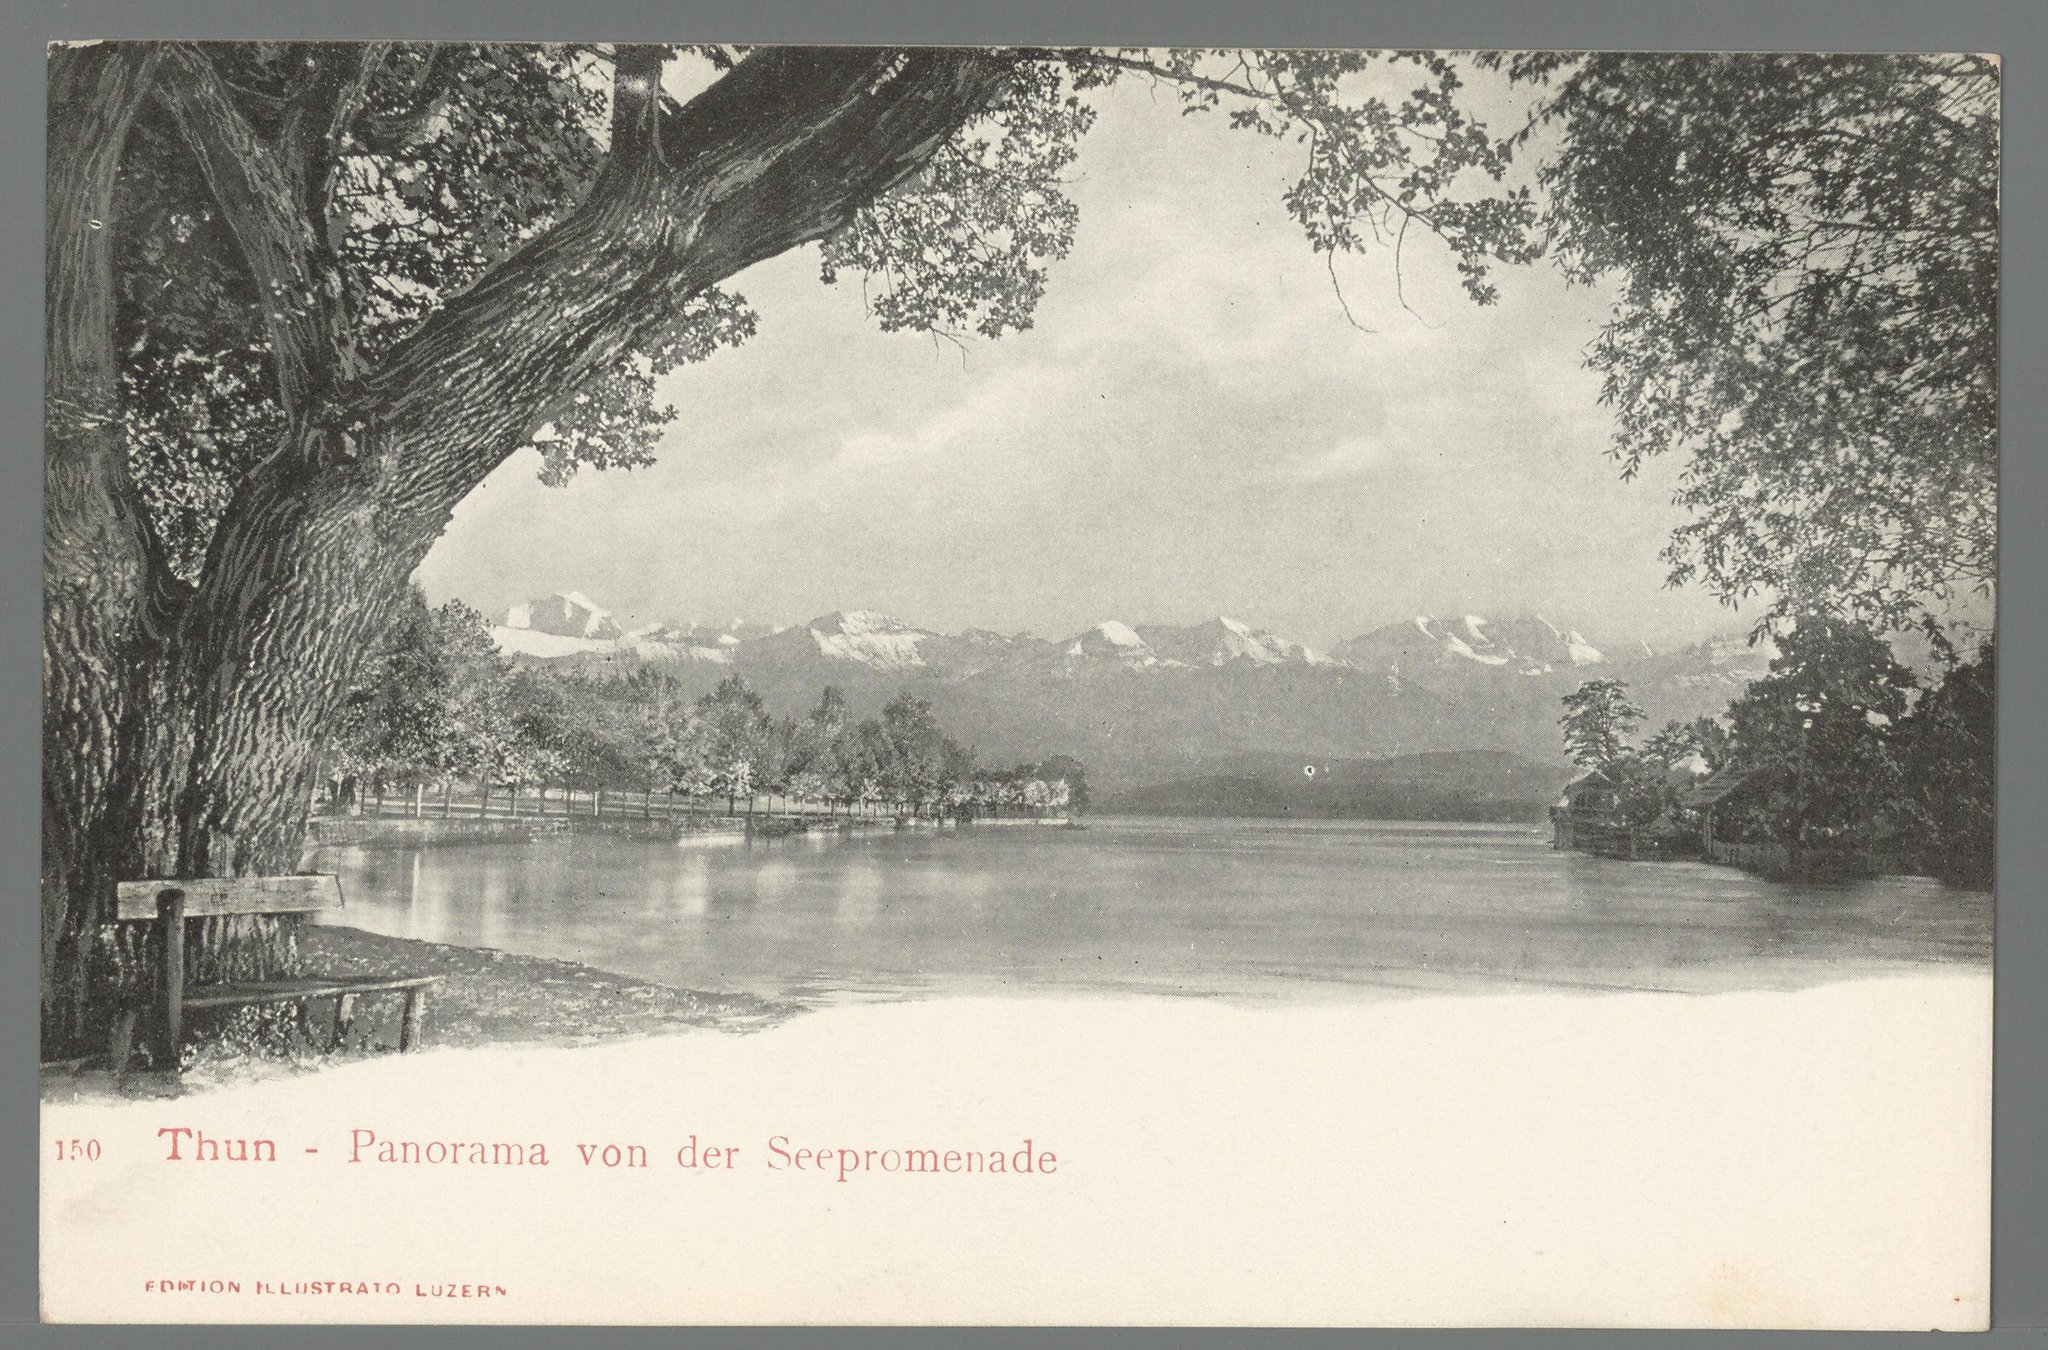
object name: ansichtkaart, prentbriefkaart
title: Thun. Panorama von der Seepromenade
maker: Anonymous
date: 1890-1905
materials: cardboard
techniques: autotype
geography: thun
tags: lake, mountain-range, snow peaks